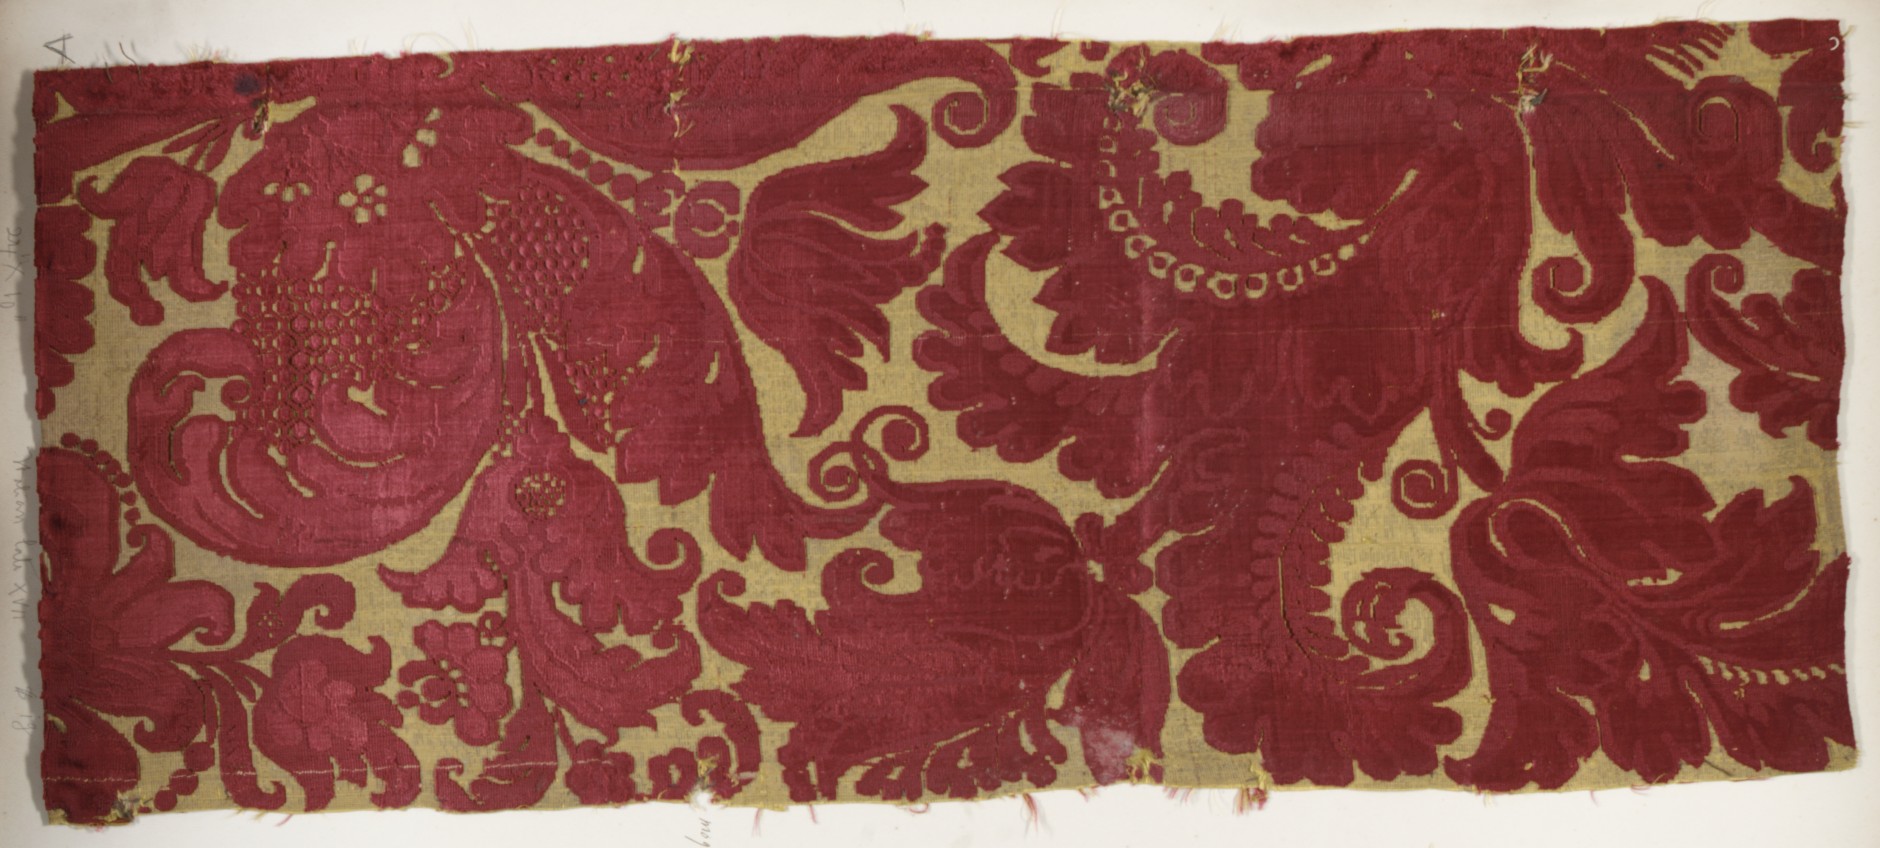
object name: fragment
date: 1601-1700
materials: metal thread, silk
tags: leaves